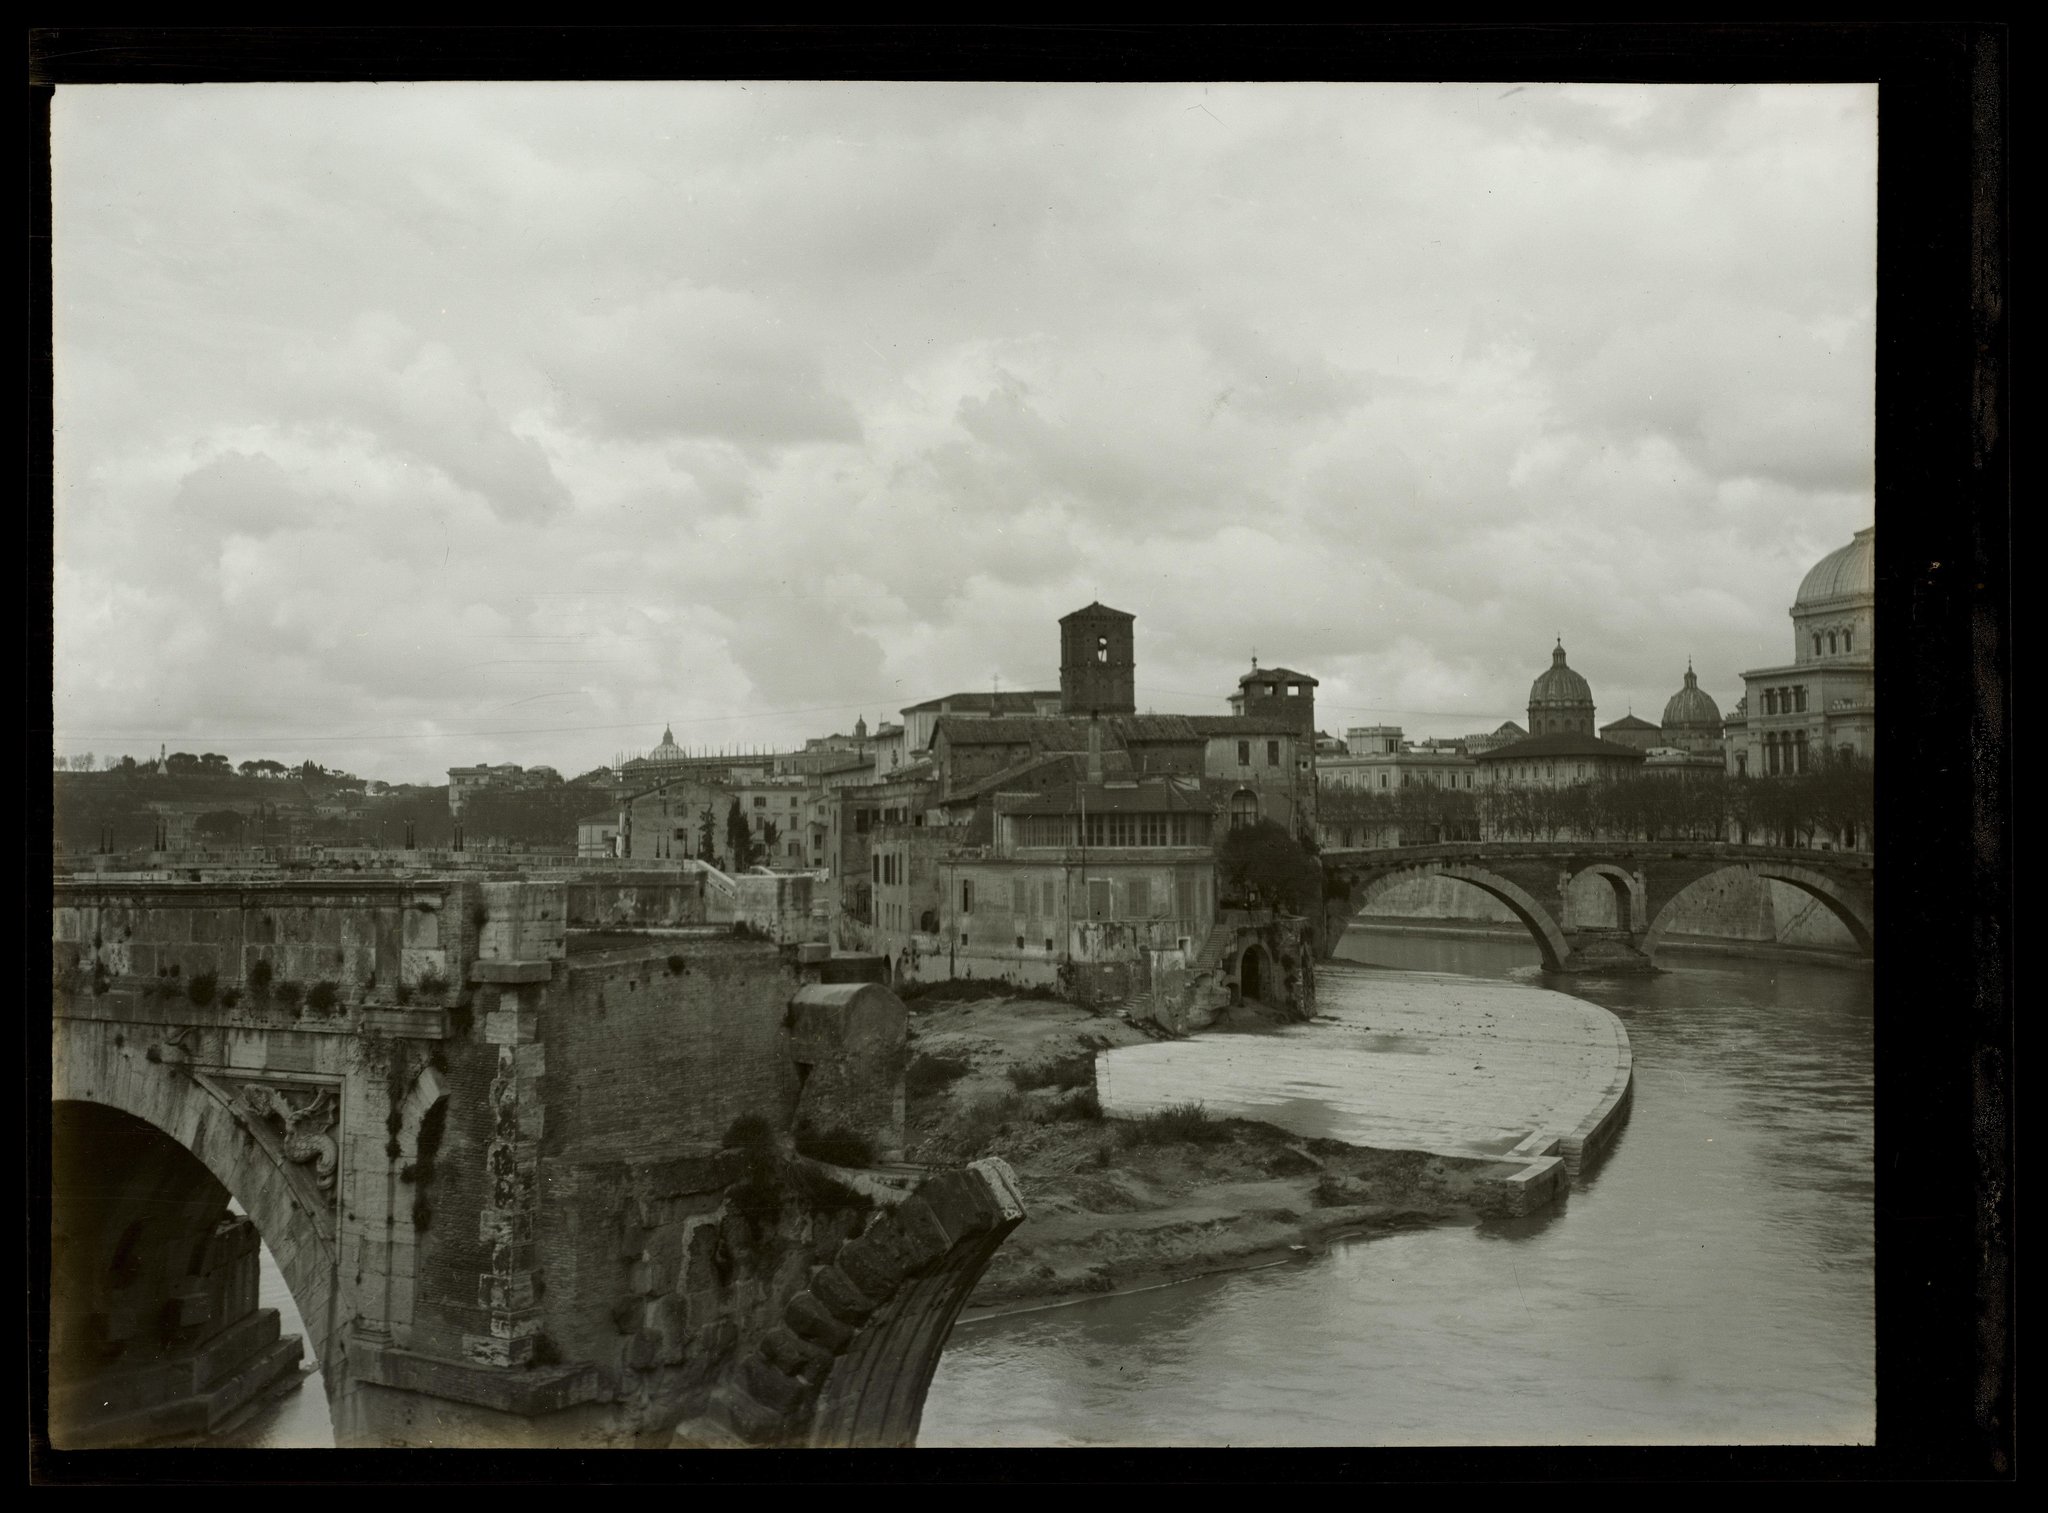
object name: negative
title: Filmnegatief met opname van Rome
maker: Anonymous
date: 1907-1935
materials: film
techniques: gelatin silver negative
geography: rome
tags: rome